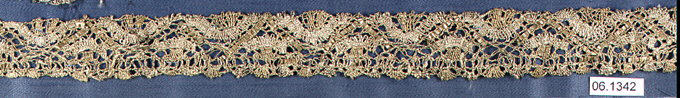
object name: strip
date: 1601-1700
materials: metal thread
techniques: lace